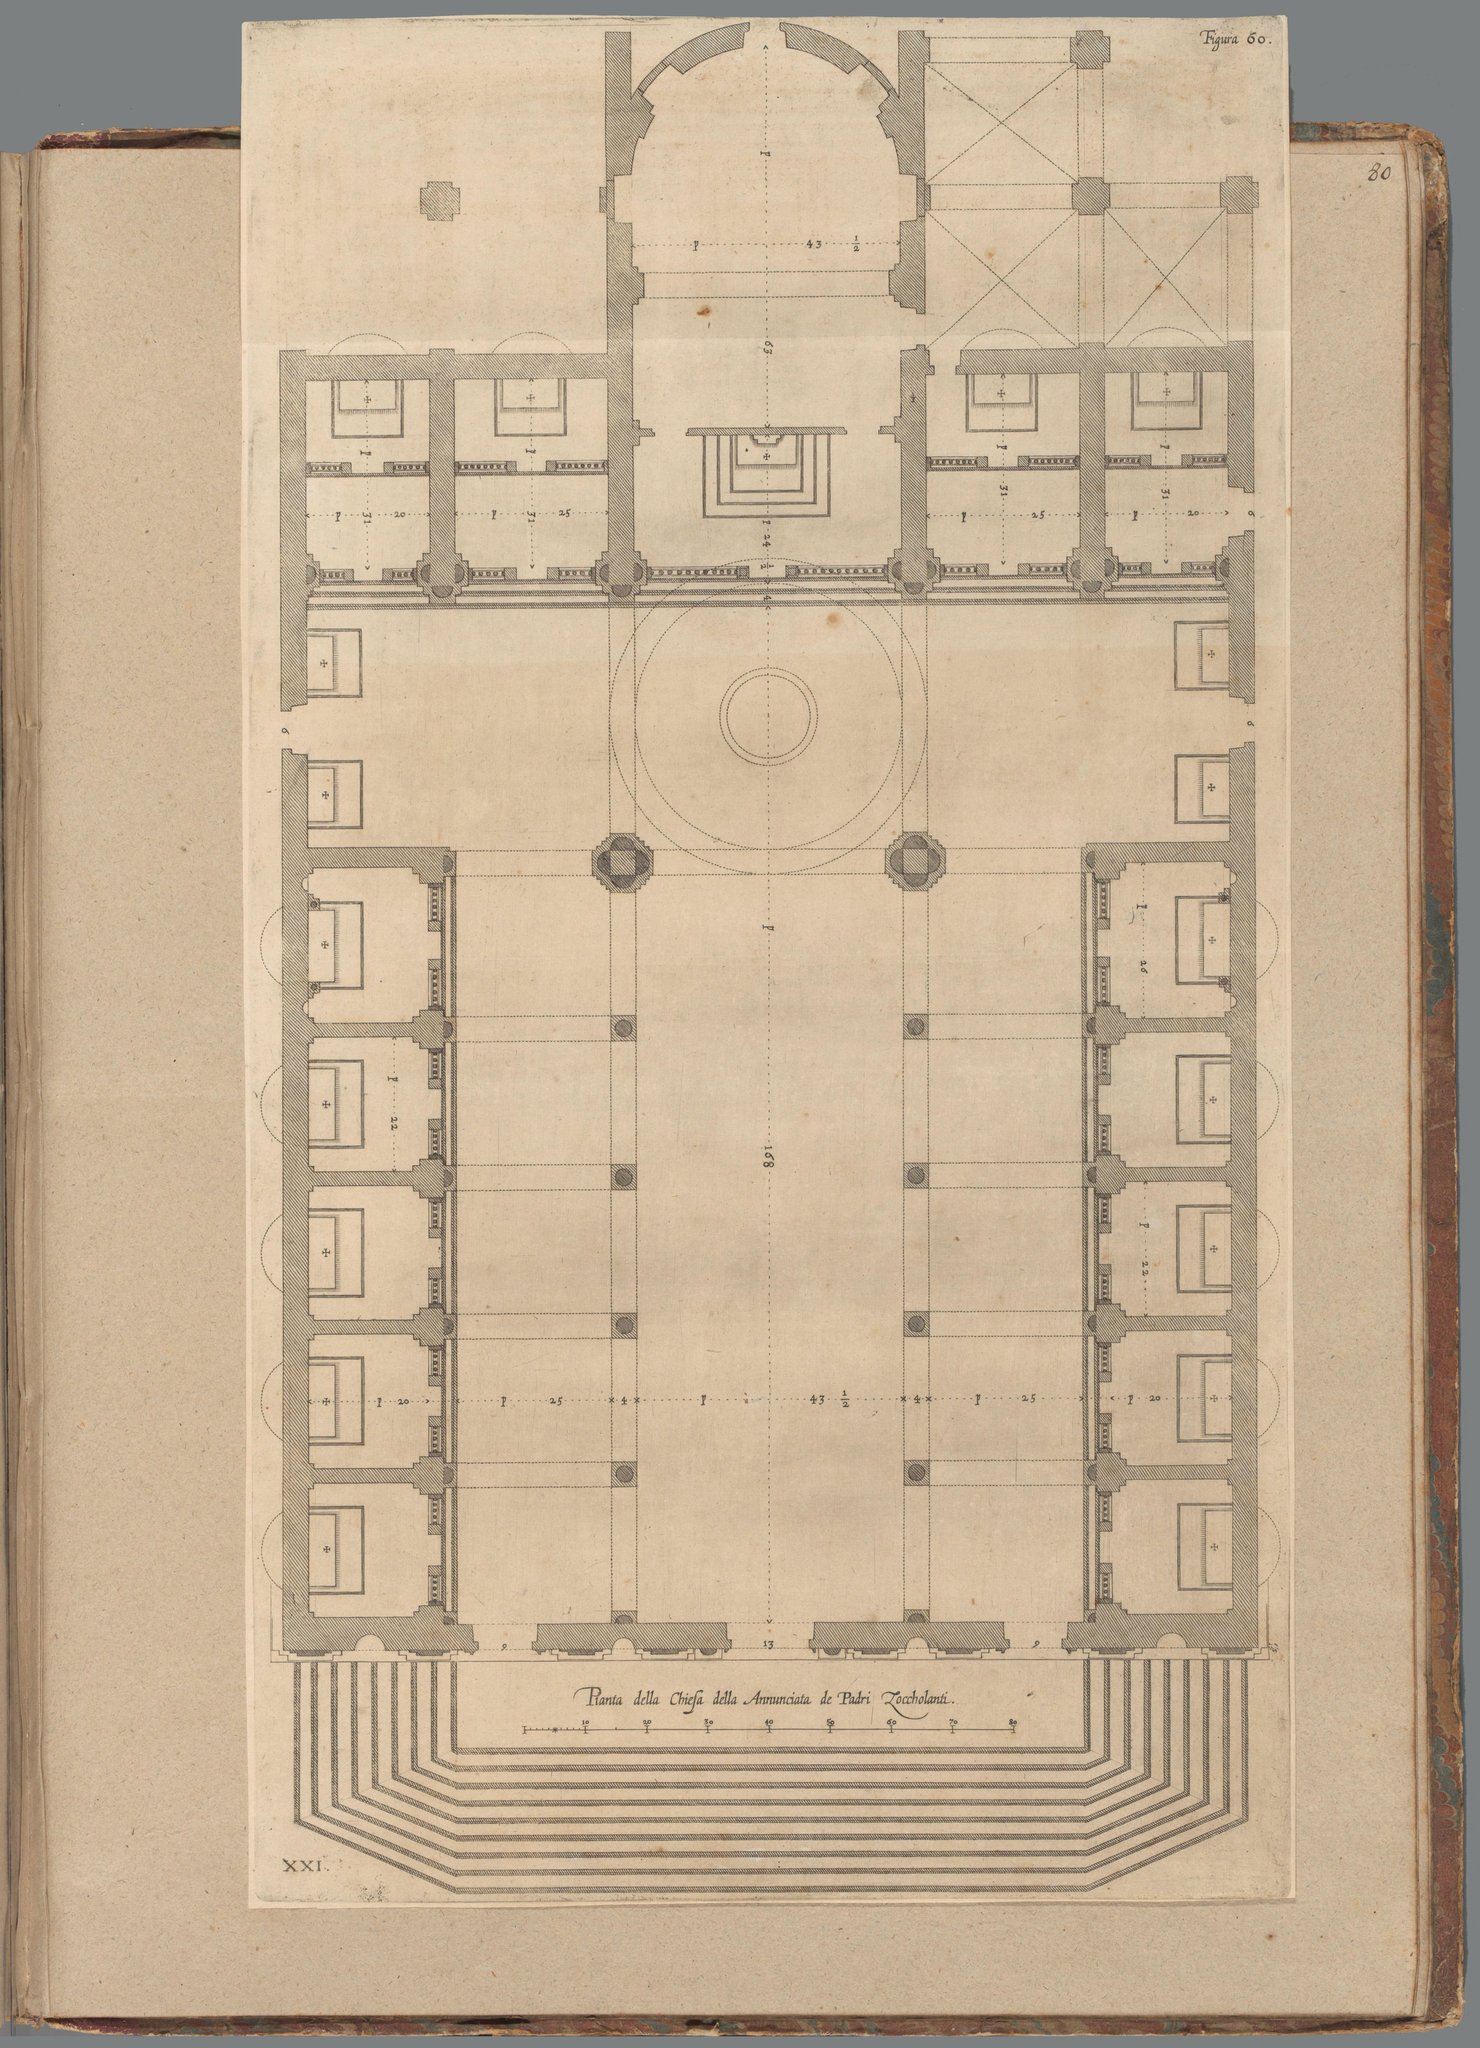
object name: album leaf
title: Pianta della chiesa della Annunciata de Padri Zoccholanti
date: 1622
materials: paper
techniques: engraving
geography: antwerp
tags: the place of worship and its equipment ~ christian churches, plan ~ architecture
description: Deze prent maakt deel uit van een album.